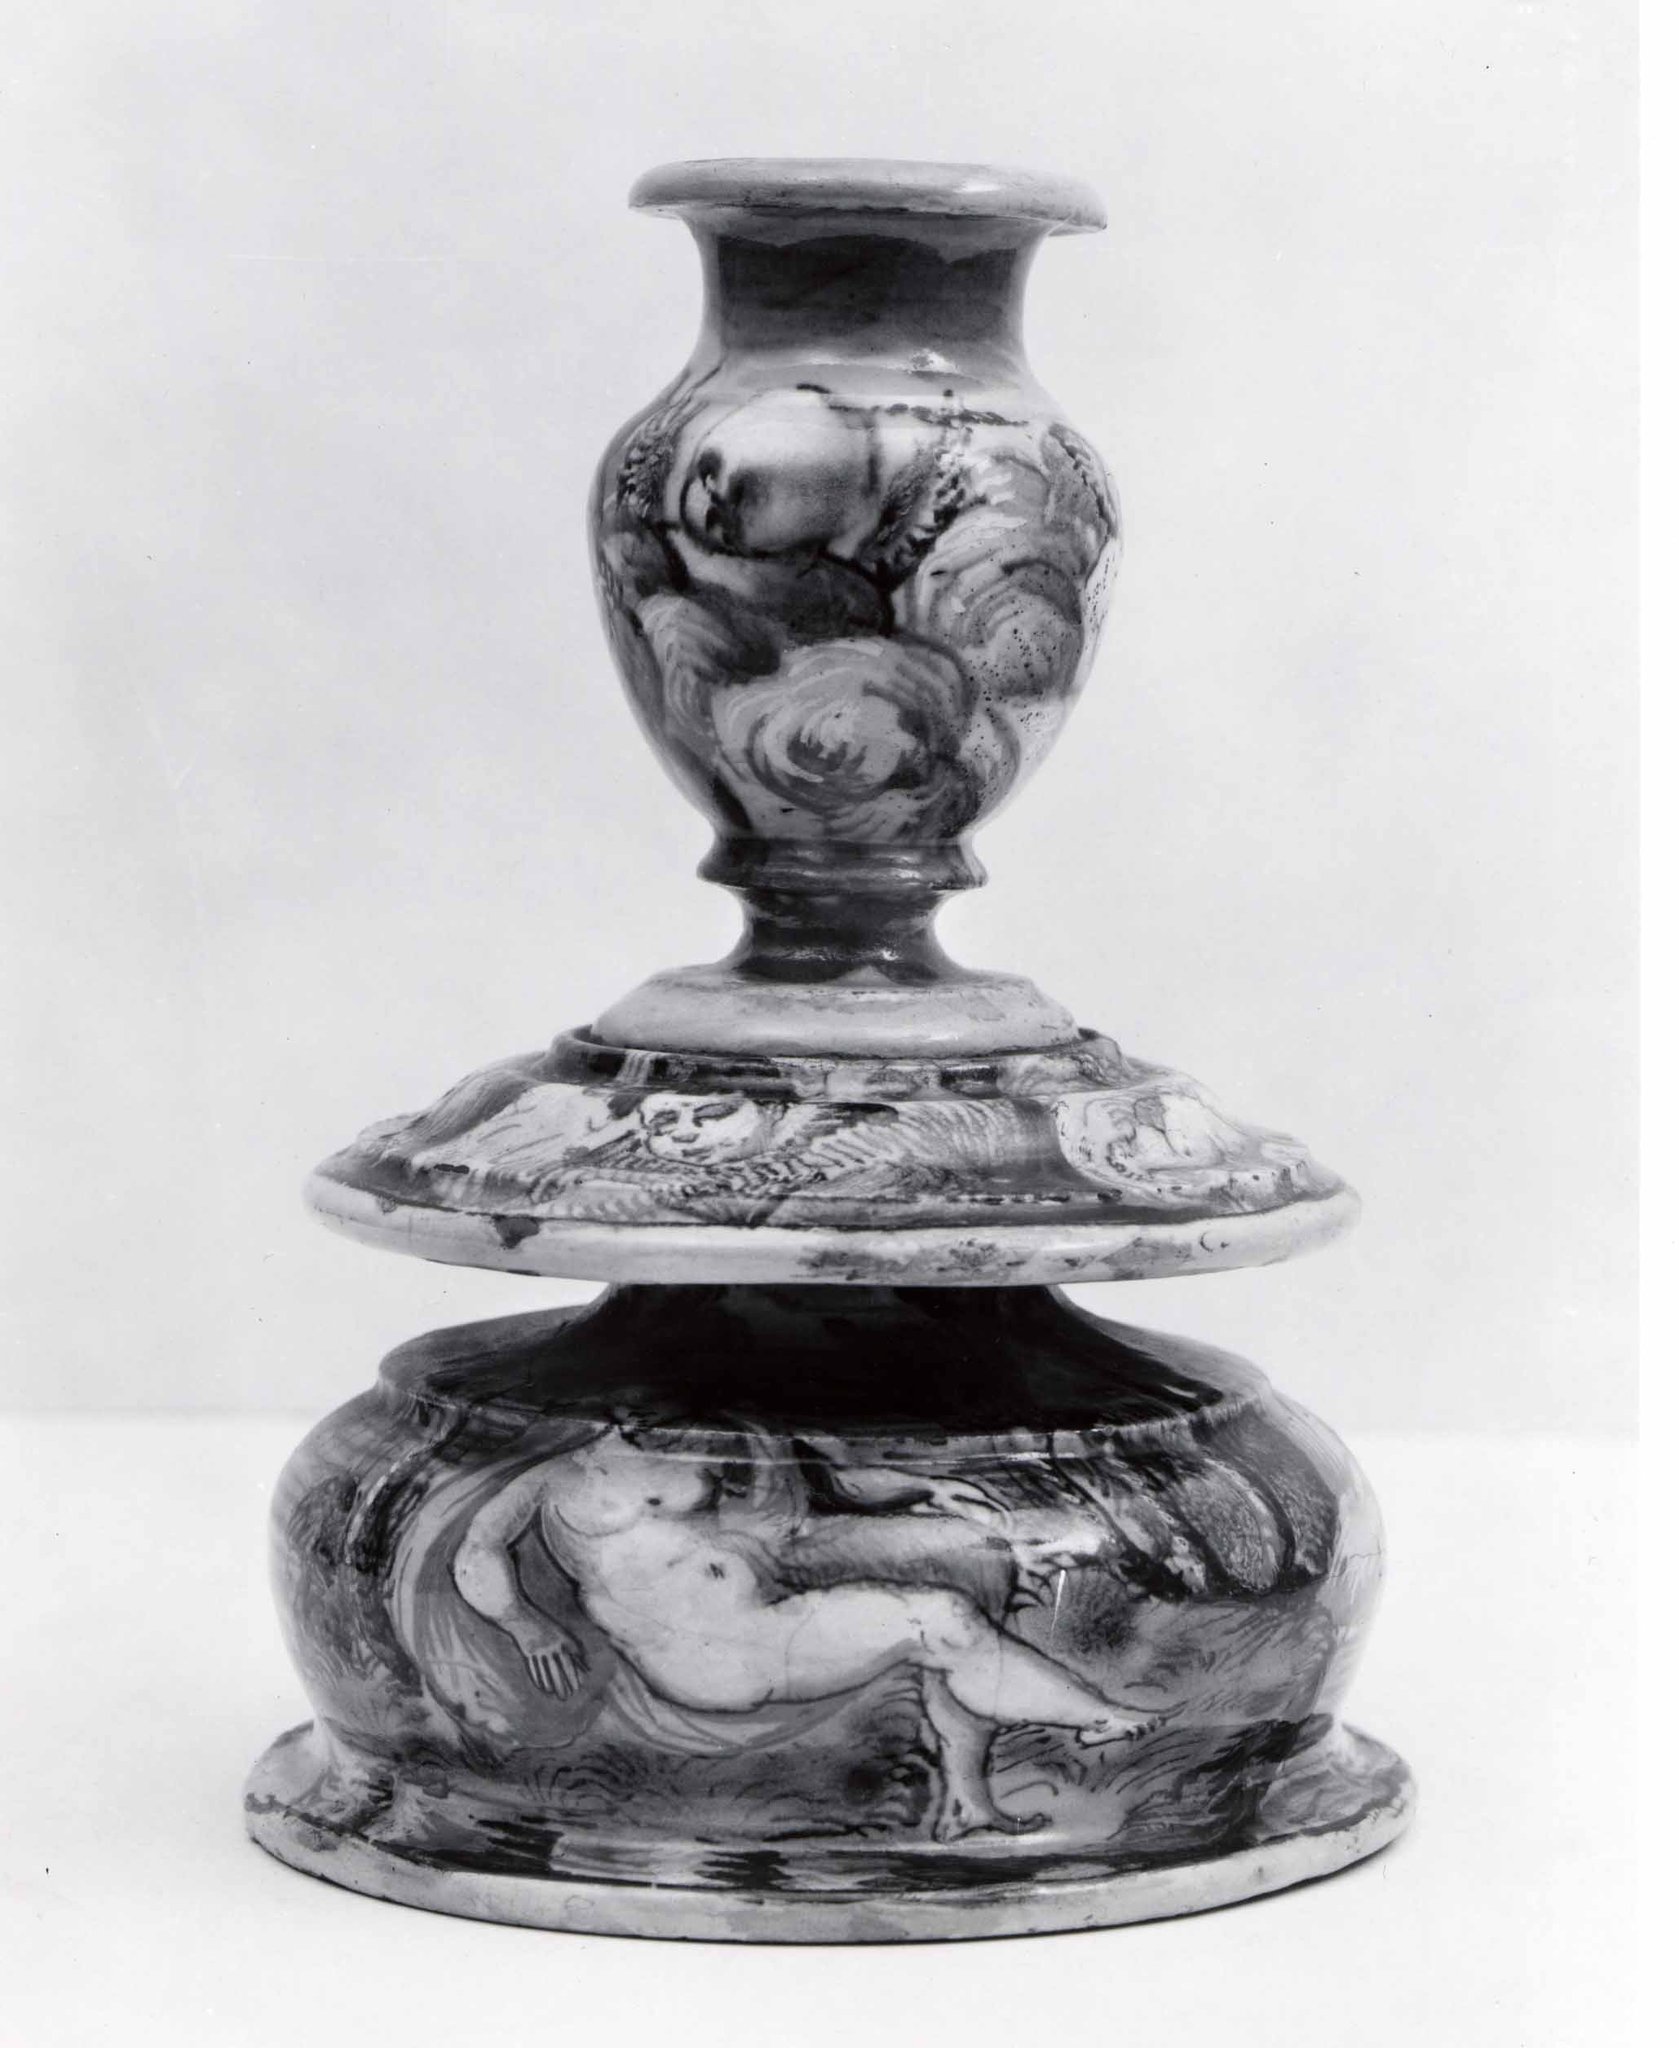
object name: candlestick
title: Candlestick (candeliere)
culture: italian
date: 1560-1580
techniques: maiolica, glazing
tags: female nudes